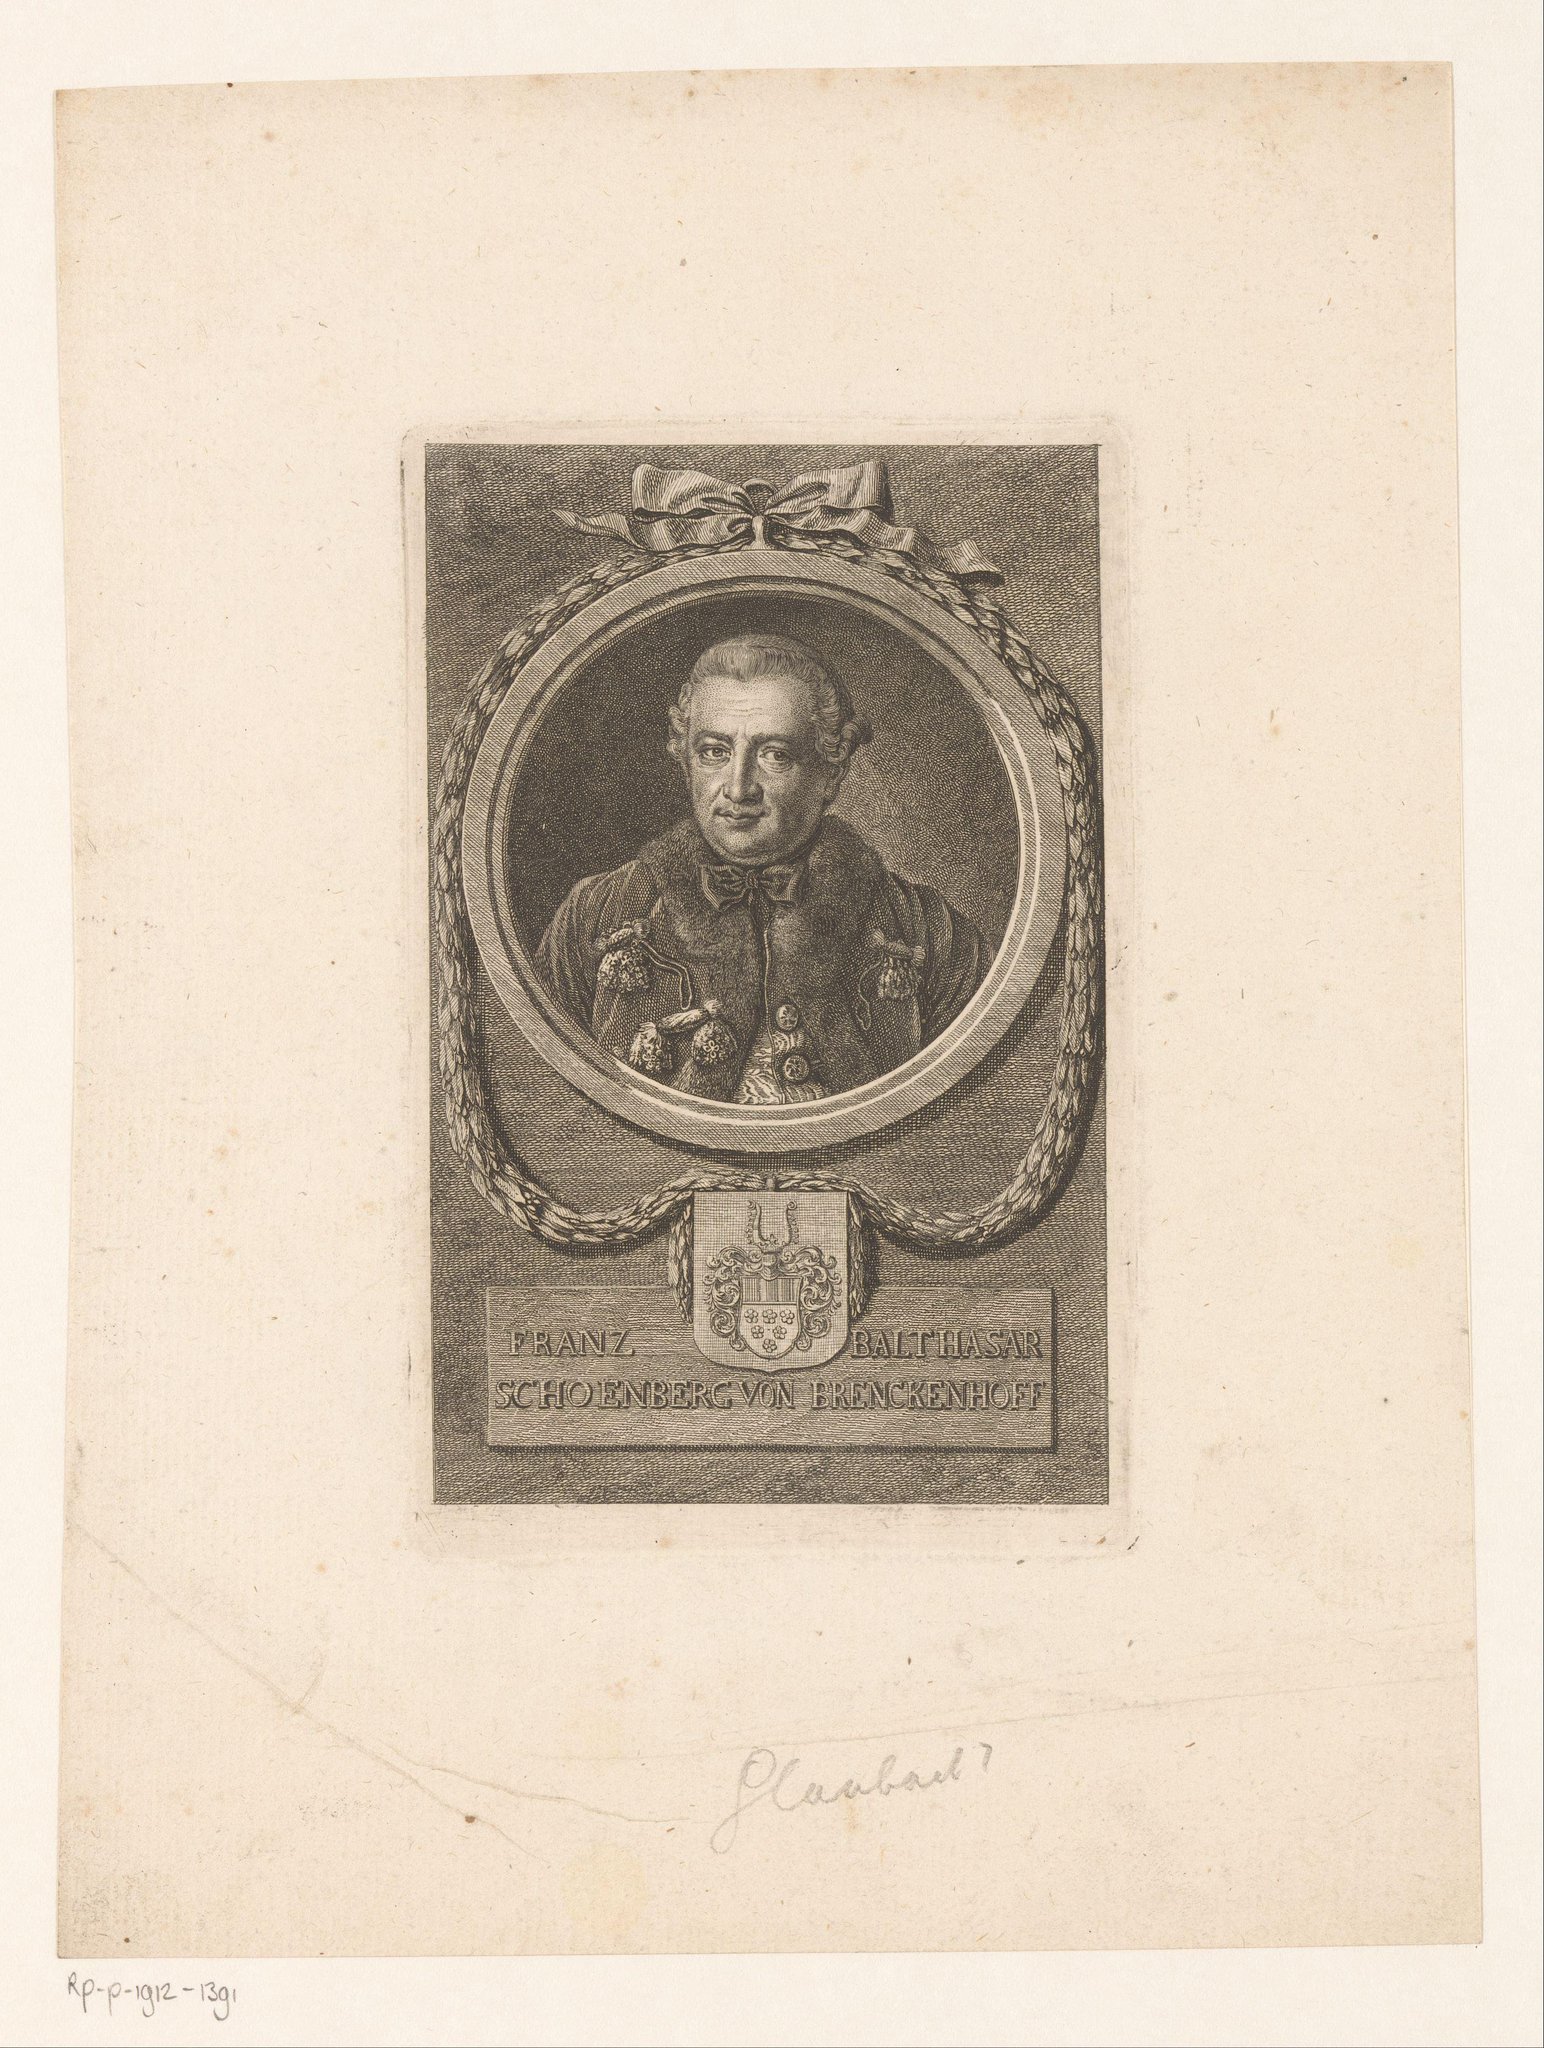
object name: print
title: Portret van Franz Balthasar Schönberg von Brenkenhoff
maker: carl christian glassbach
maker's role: print maker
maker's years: 1751-1789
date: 1761-1789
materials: paper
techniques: engraving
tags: ornament ~ medallion, historical persons, ornament ~ festoon, garland, armorial bearing, heraldry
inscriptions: collector's mark: Lugt 2228